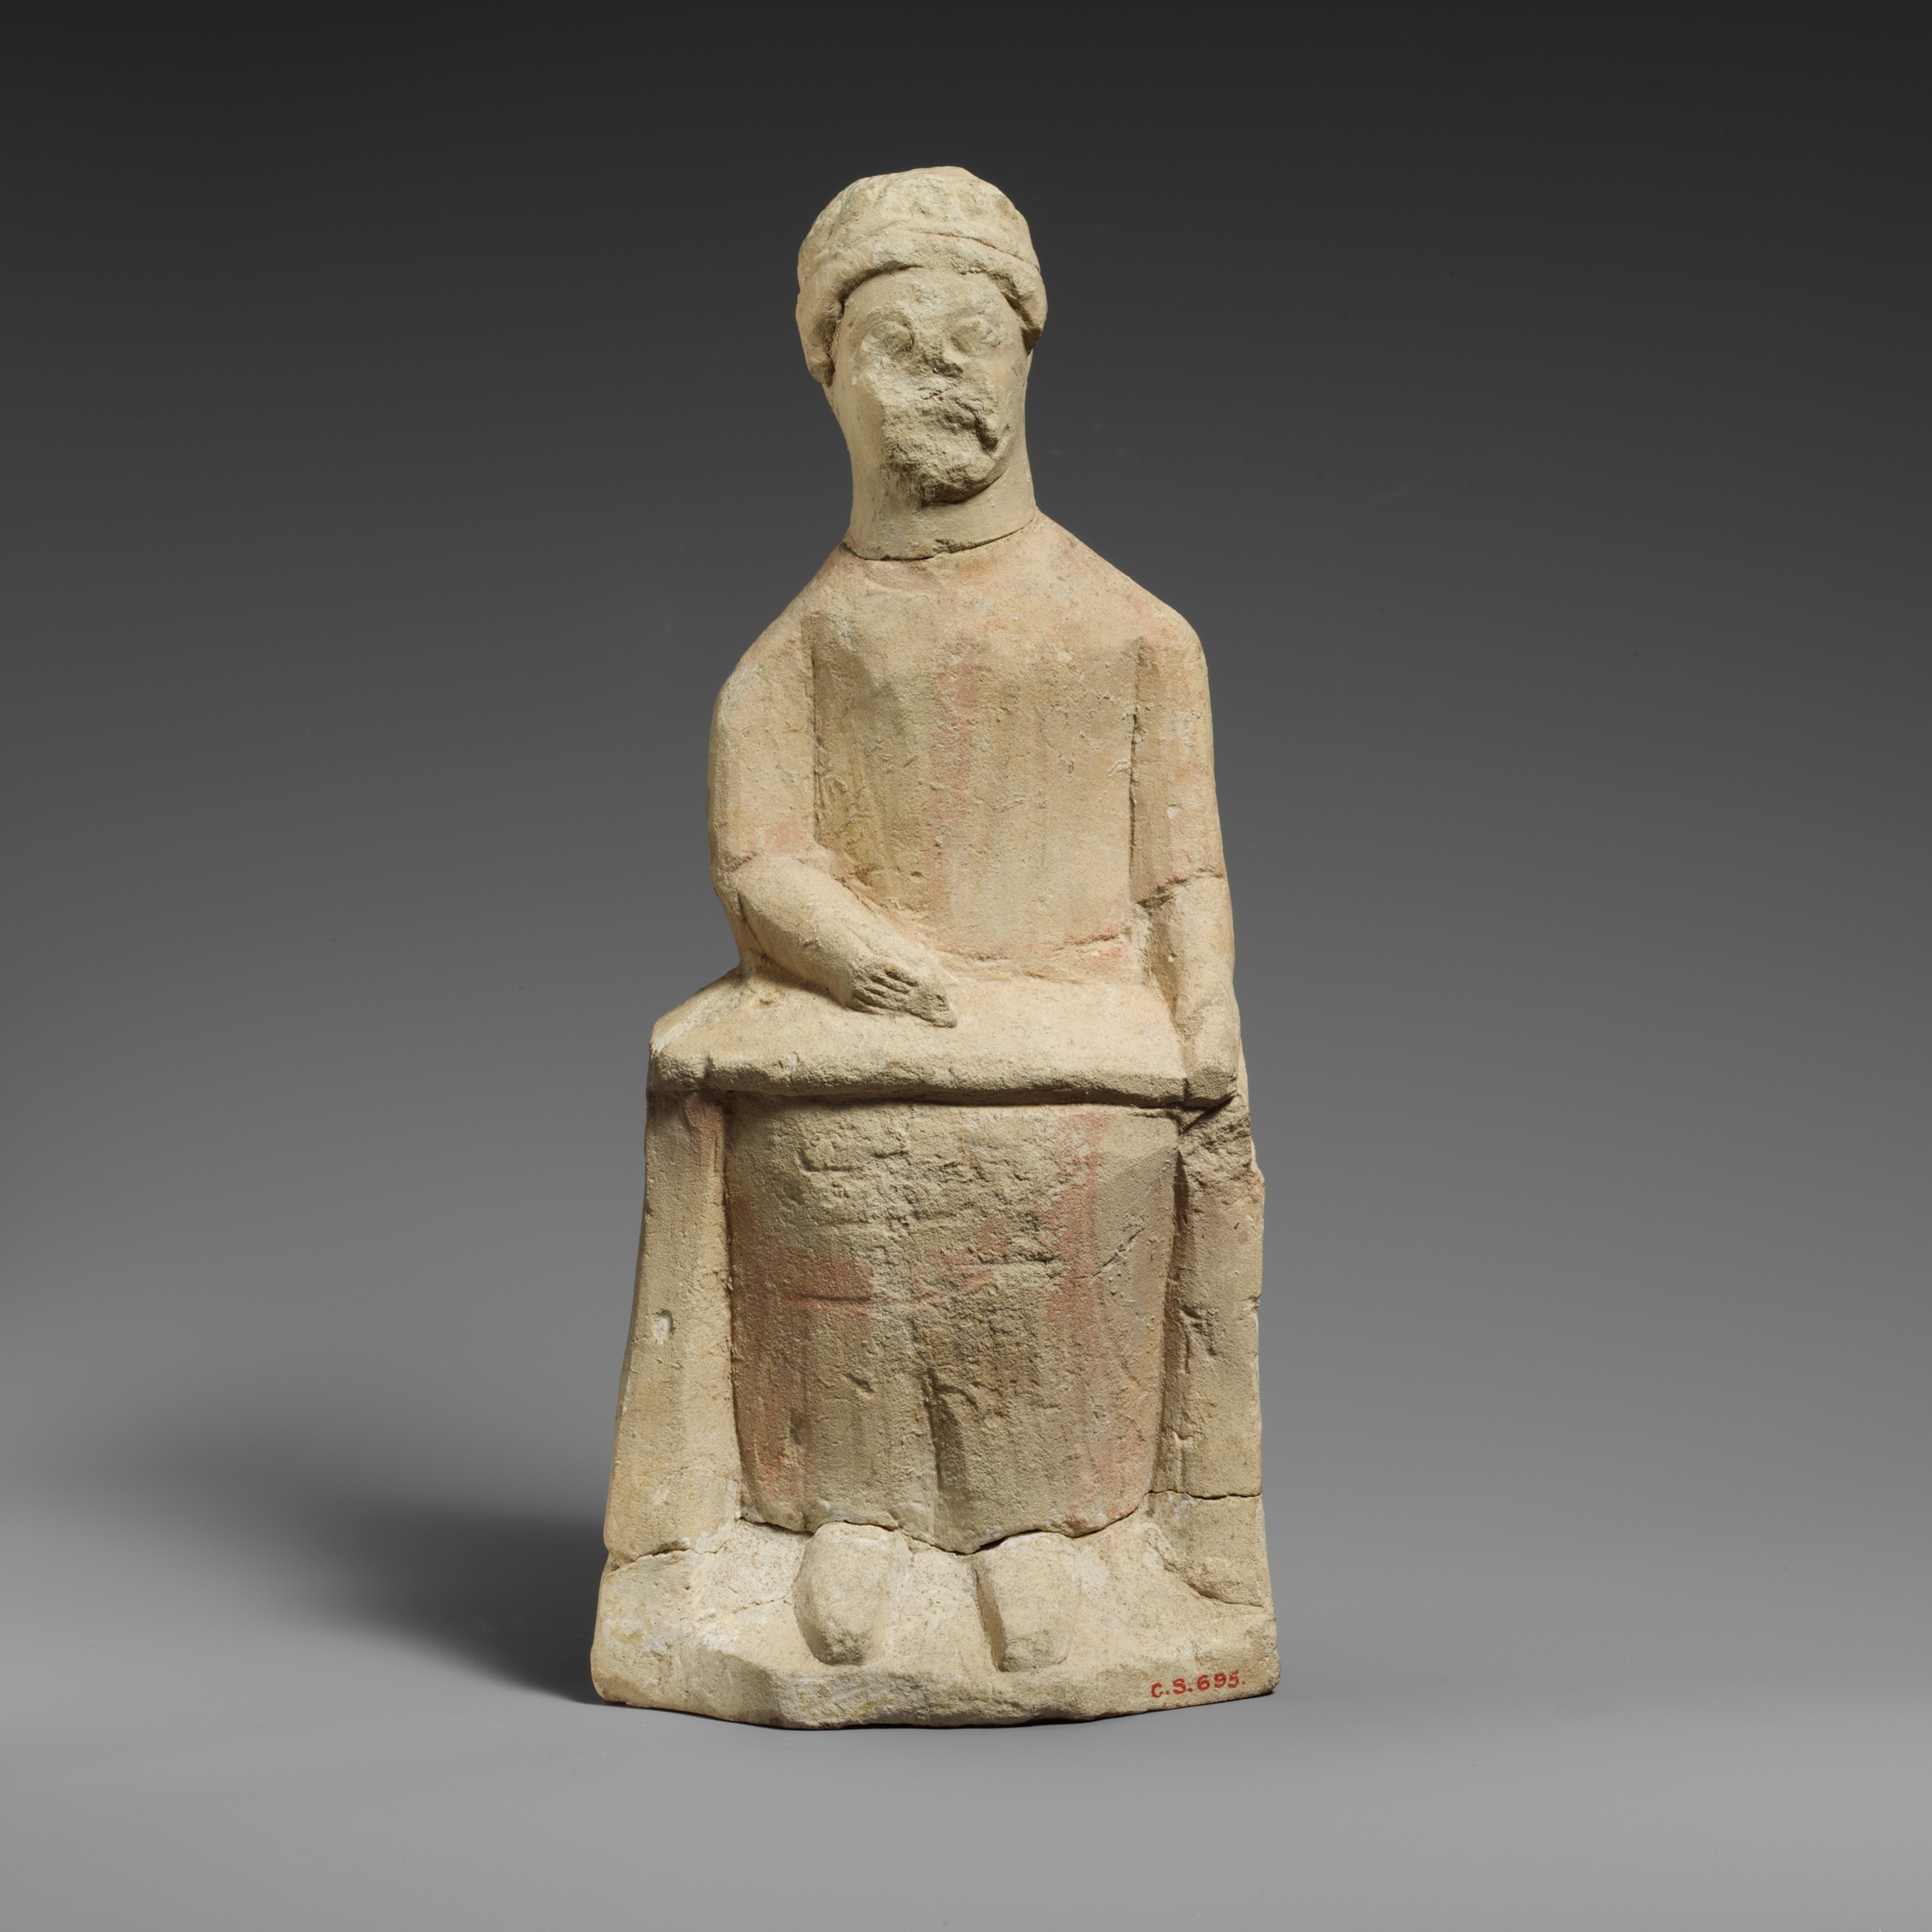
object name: statuette of a poet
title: Limestone statuette of a seated beardless male votary writing on a scroll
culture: cypriot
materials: limestone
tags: men,writing